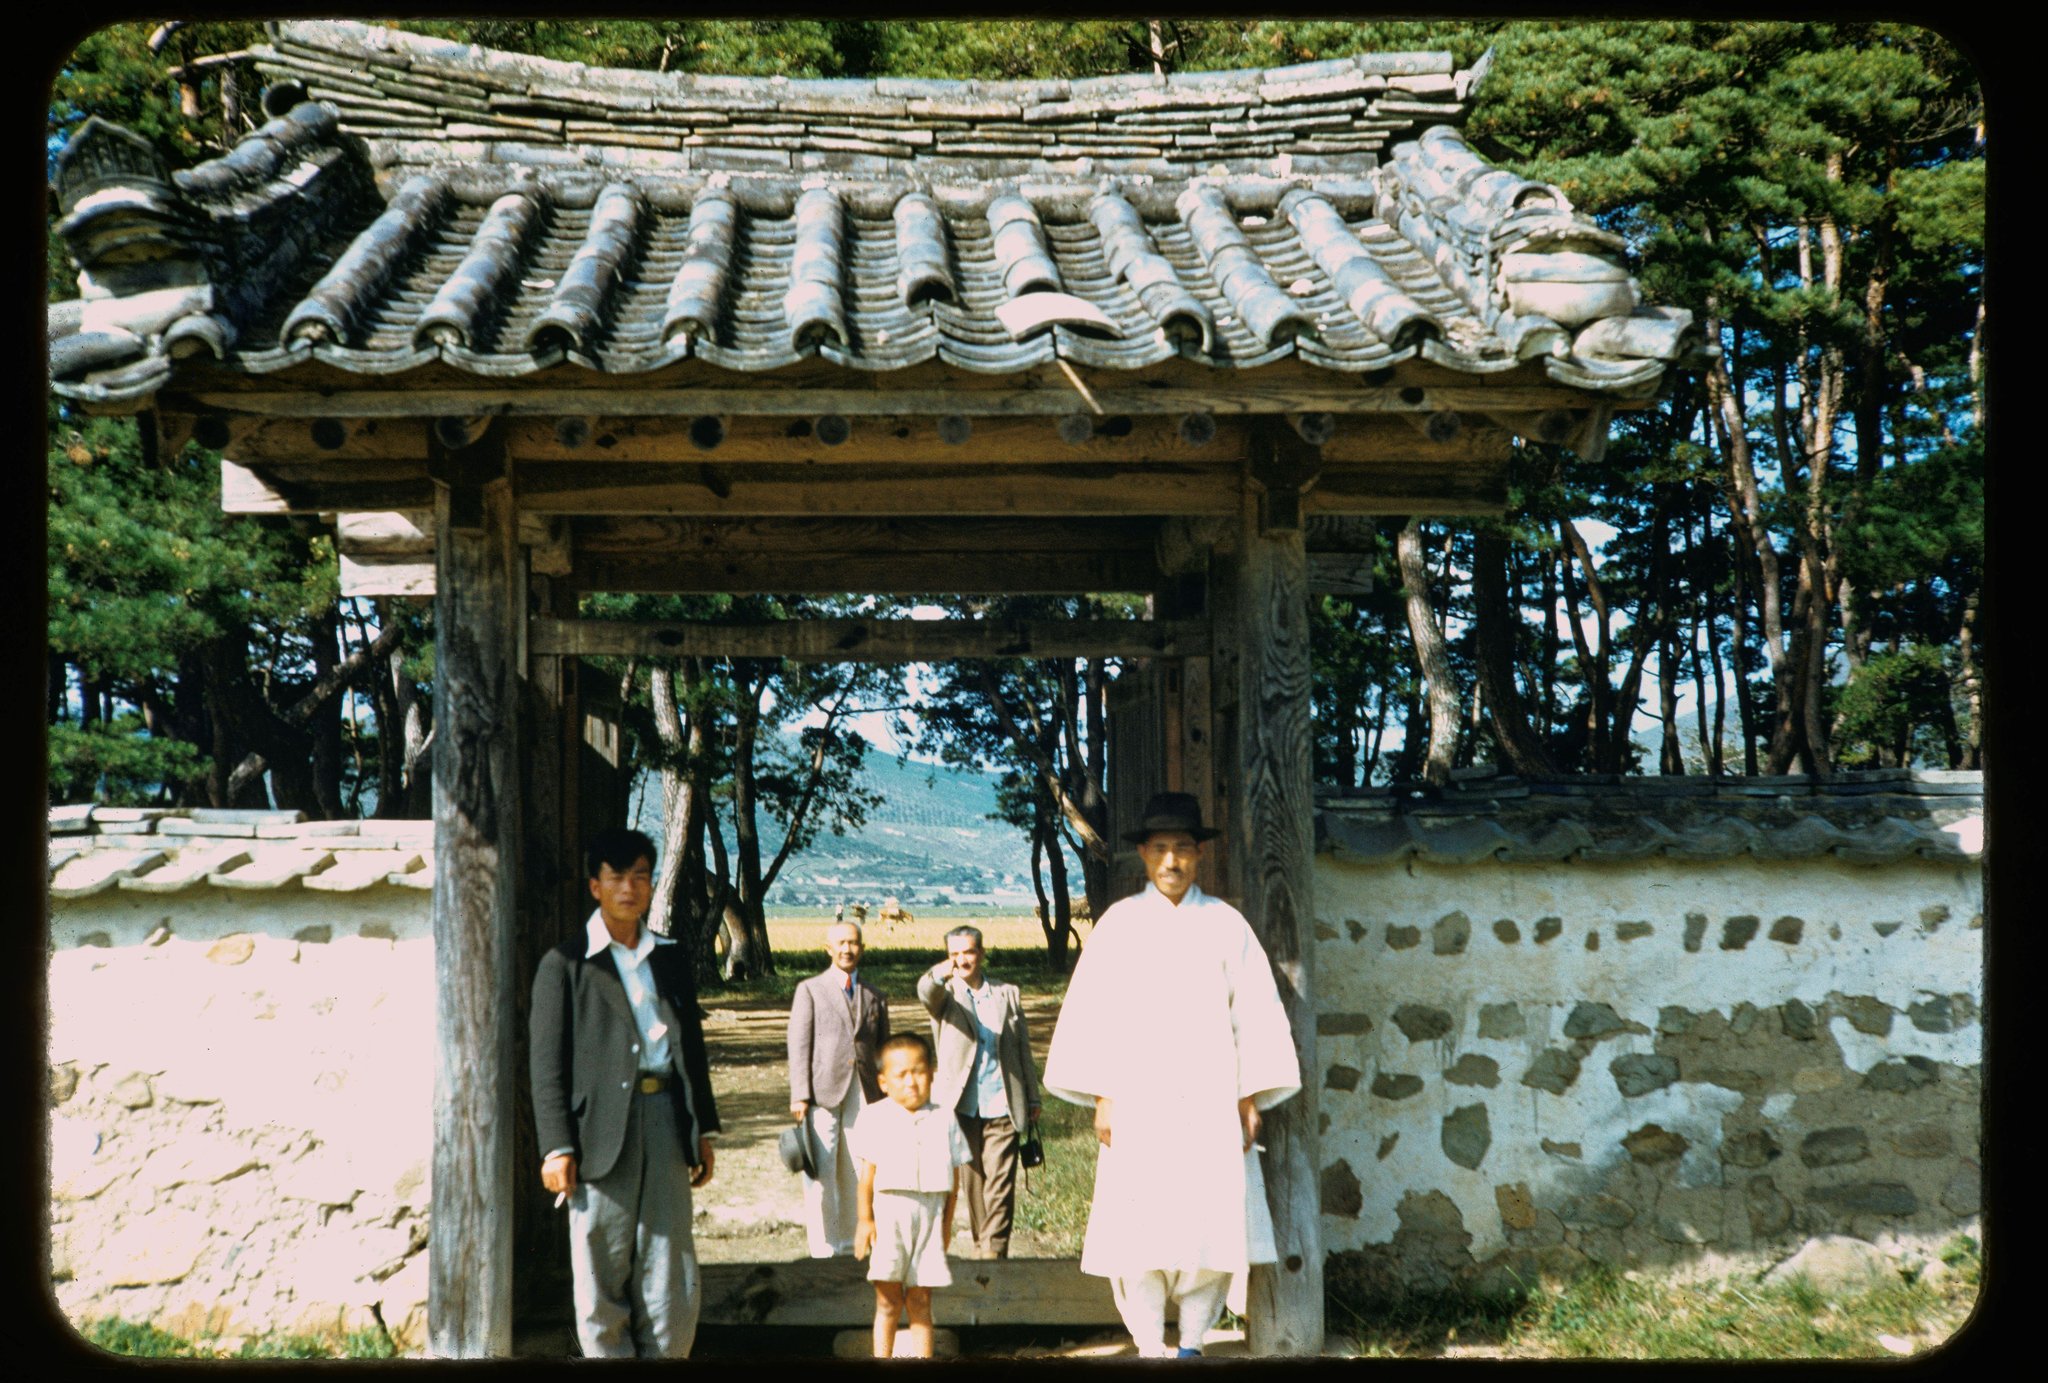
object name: color slide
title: Oorlog in Korea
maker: david ketel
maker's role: diplomaat, sinoloog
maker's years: 1913-2008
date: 1952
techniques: slide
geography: korea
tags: united nations